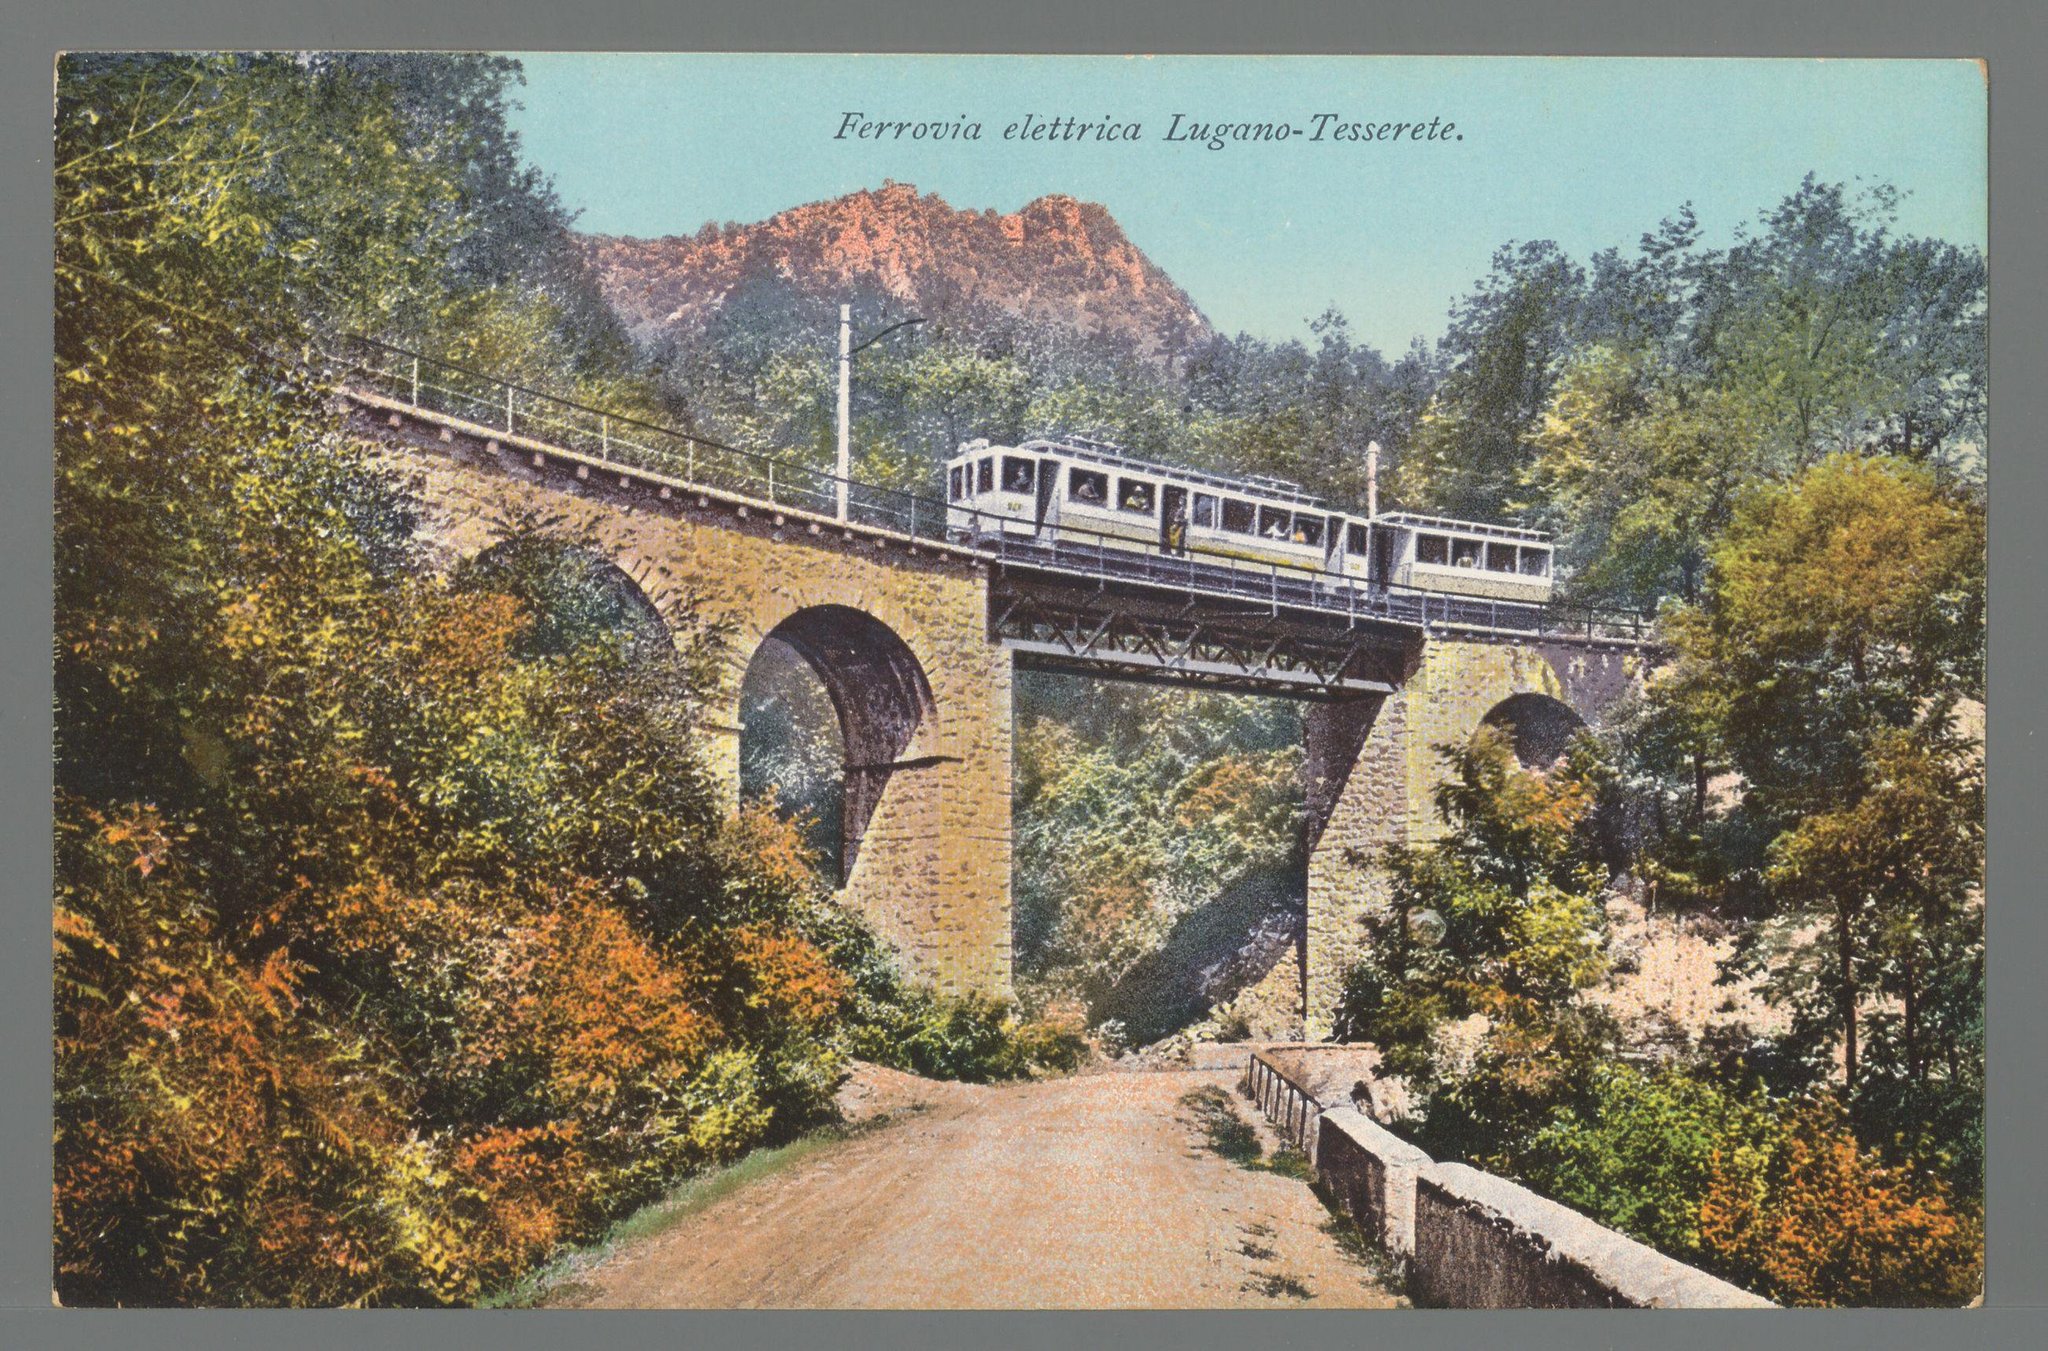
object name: photomechanical print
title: Ferrovia elettrica Lugano-Tesserete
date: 1905-1920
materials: cardboard, photographic process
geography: ticino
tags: landscape with bridge, viaduct or aqueduct, railway, train, mountains